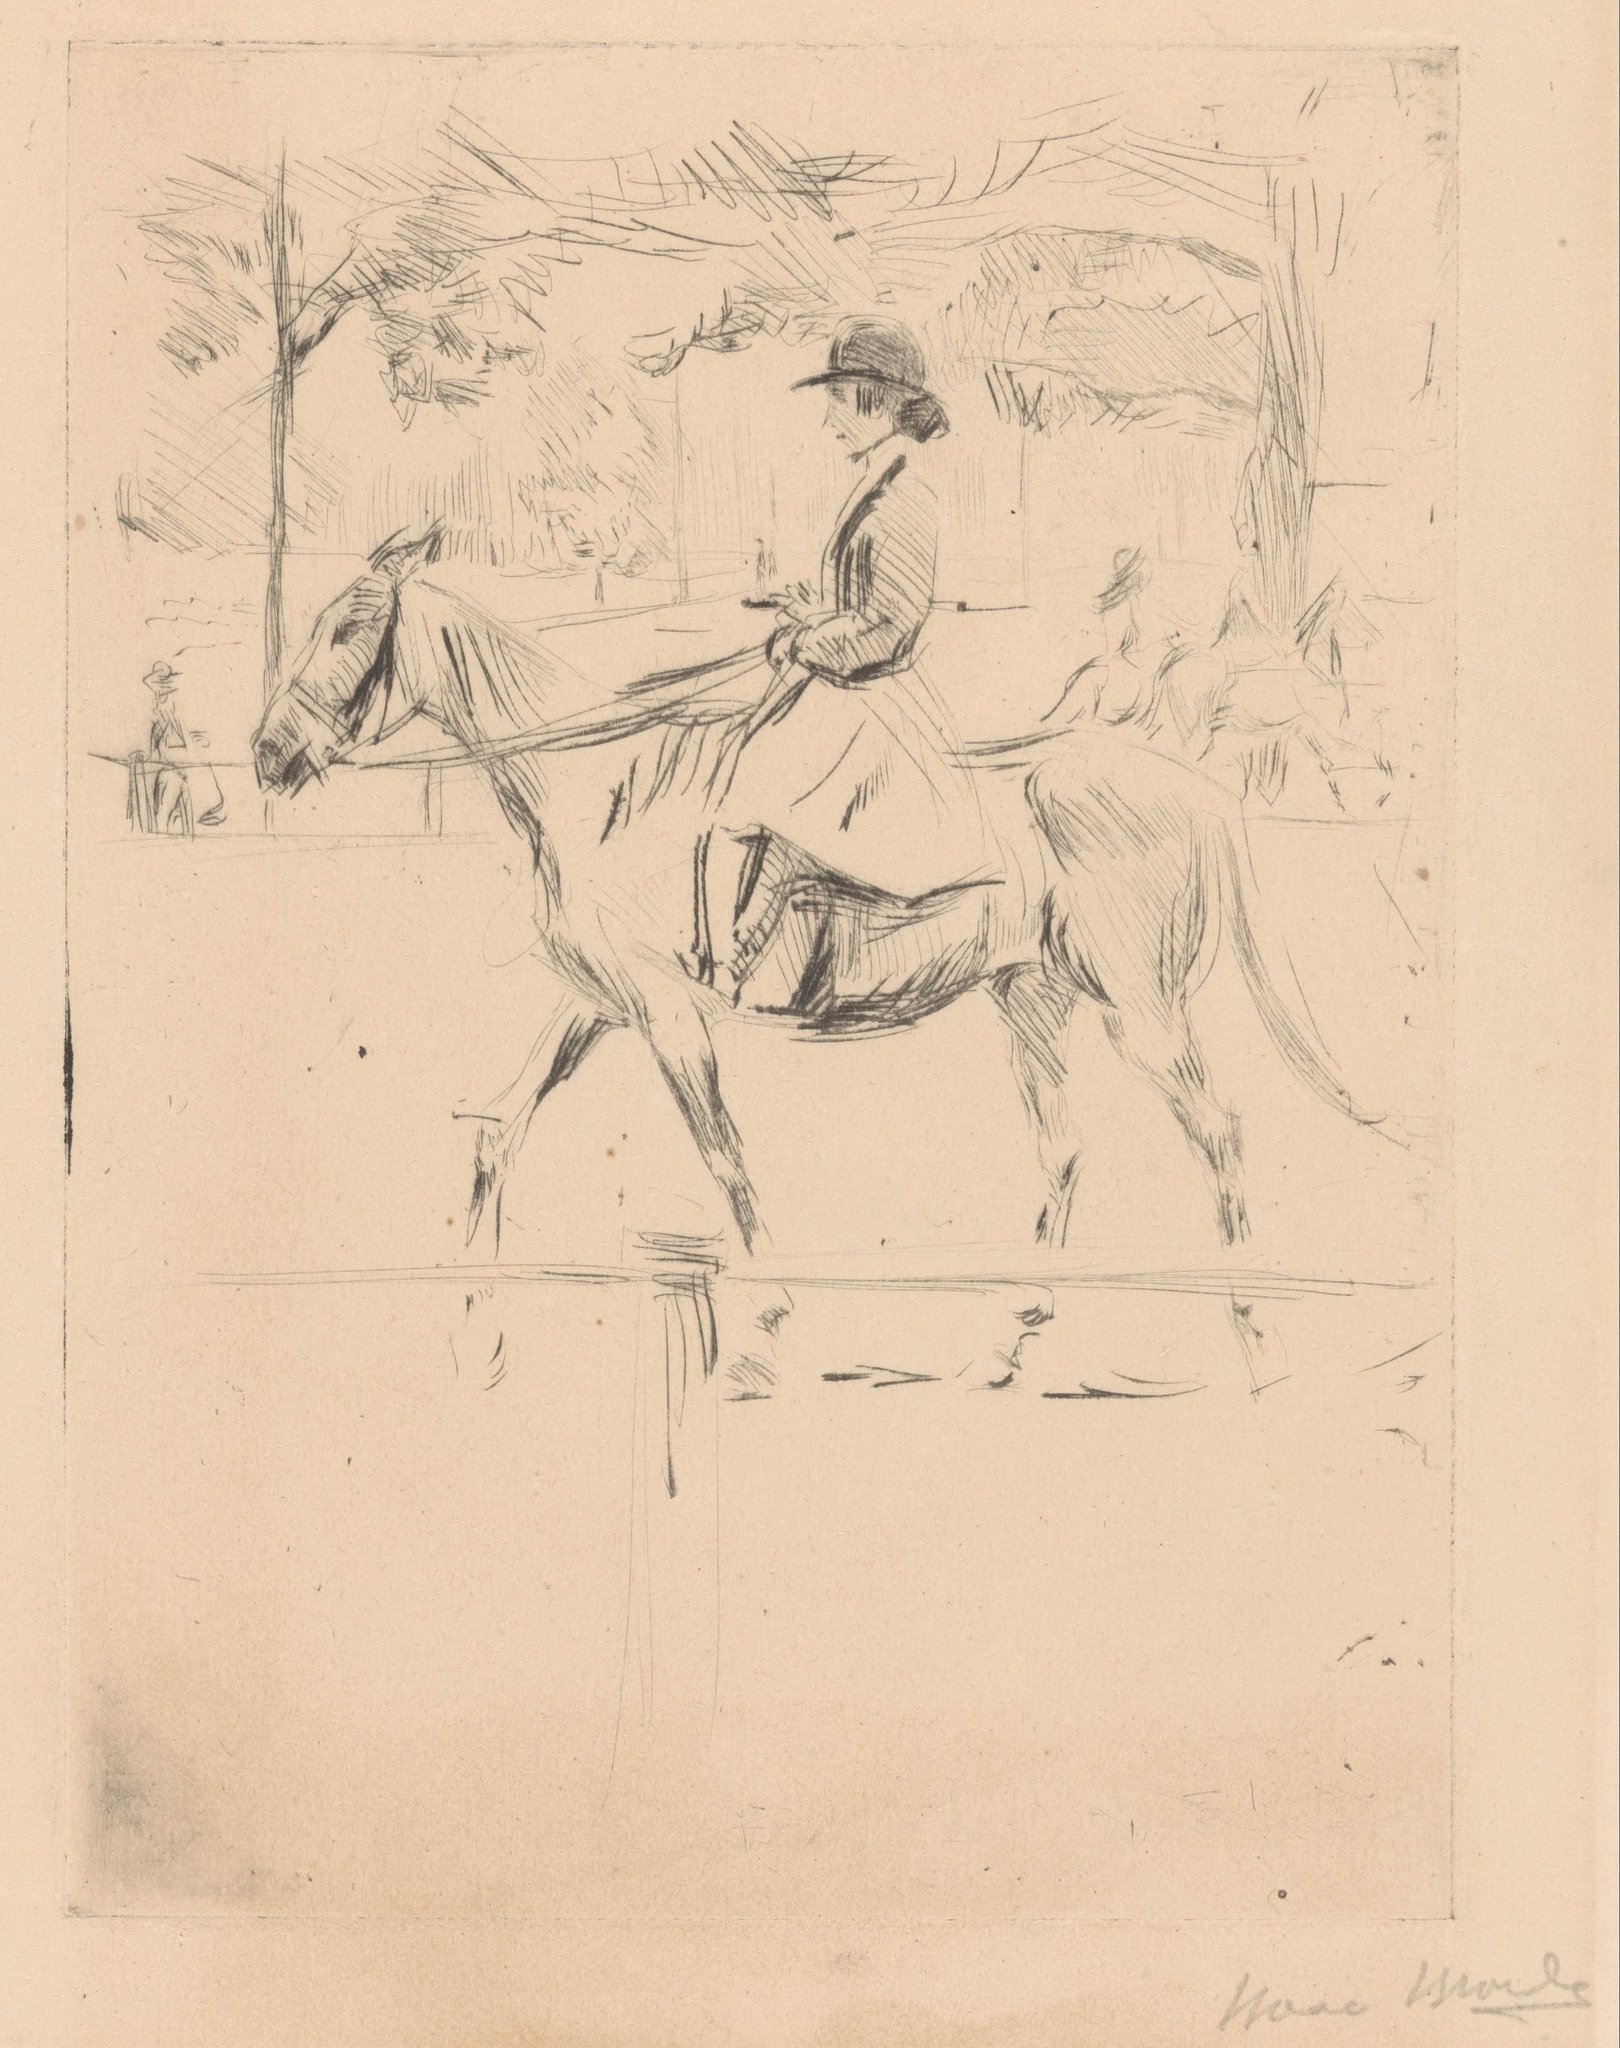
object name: print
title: Vrouw te paard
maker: isaac israels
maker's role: draughtsman, painter, print maker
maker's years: 1865-1934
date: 1878-1934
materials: paper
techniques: etching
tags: riding a horse, ass, or mule; rider, horseman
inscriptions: collector's mark: Lugt 2228, collector's mark: Lugt 2760